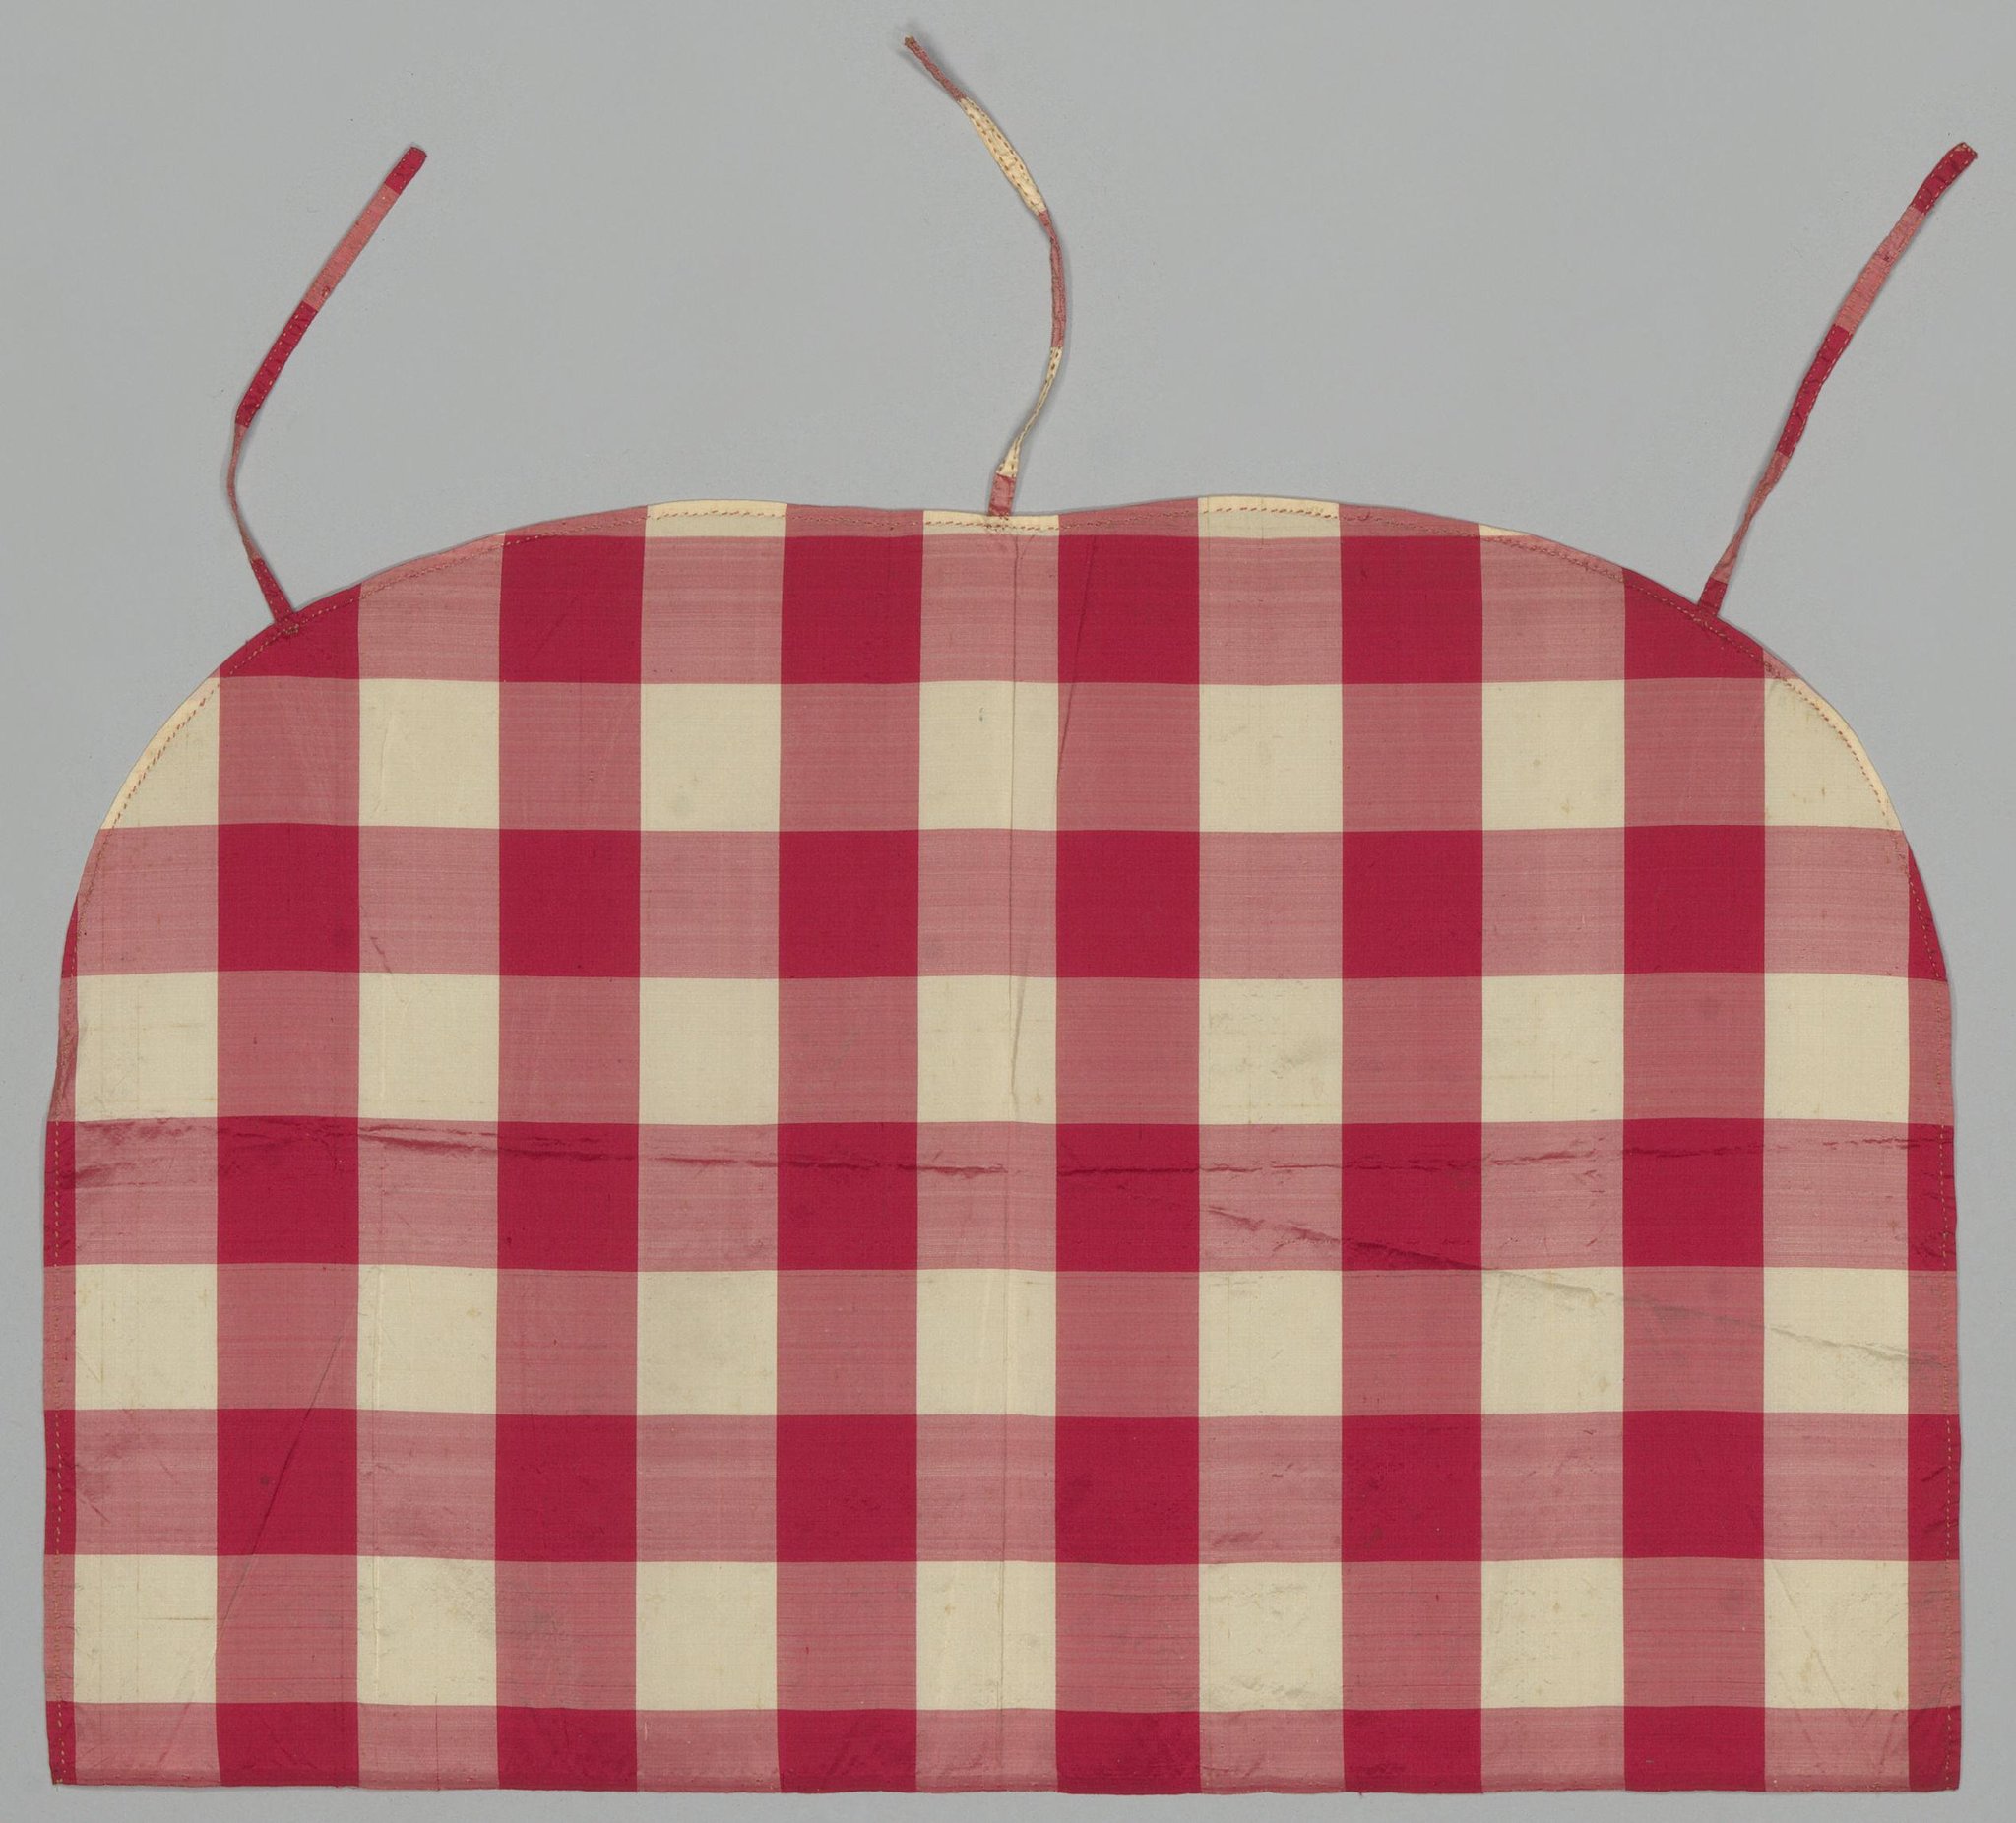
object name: gordijngarnituur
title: Gordijngarnituur, mogelijk een gordijnval, van rood-wit geblokte zijde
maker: Anonymous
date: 1776-1800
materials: silk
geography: northern netherlands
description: Schildvormig gordijngarnituur, mogelijk een gordijnval, van rood-wit geblokte zijde, met drie bandjes van dezelfde stof van ca. 10.0 cm.